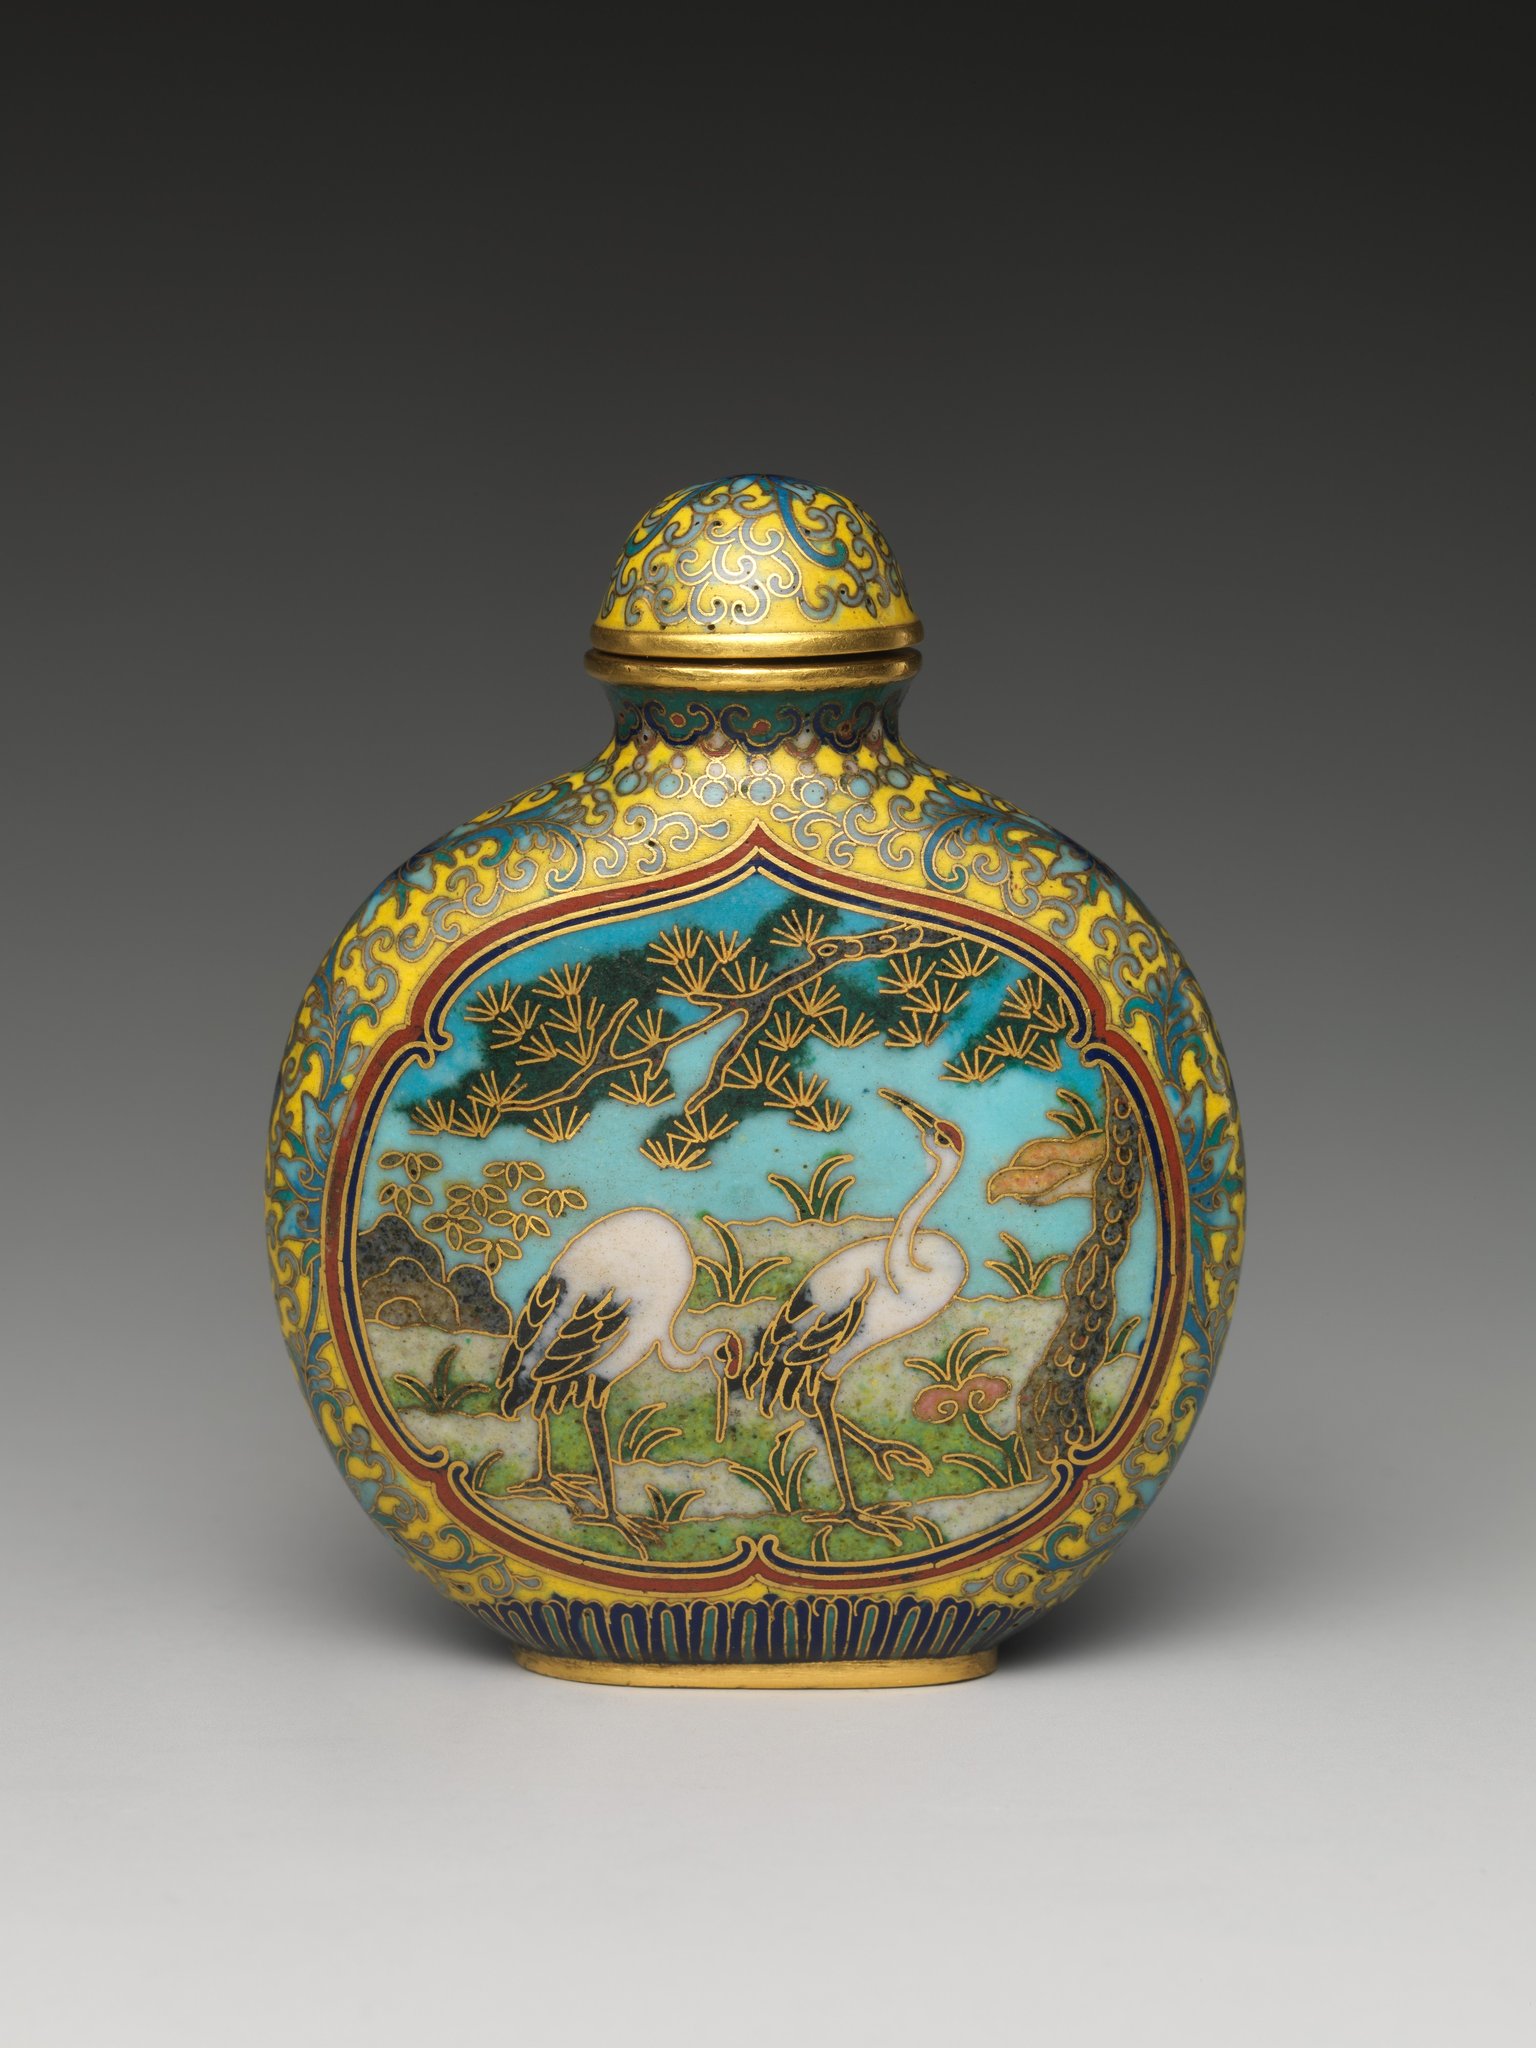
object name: snuff bottle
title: Snuff Bottle with Cranes under a Pine Tree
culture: chinese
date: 1736-1795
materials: enamel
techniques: enamel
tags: cranes